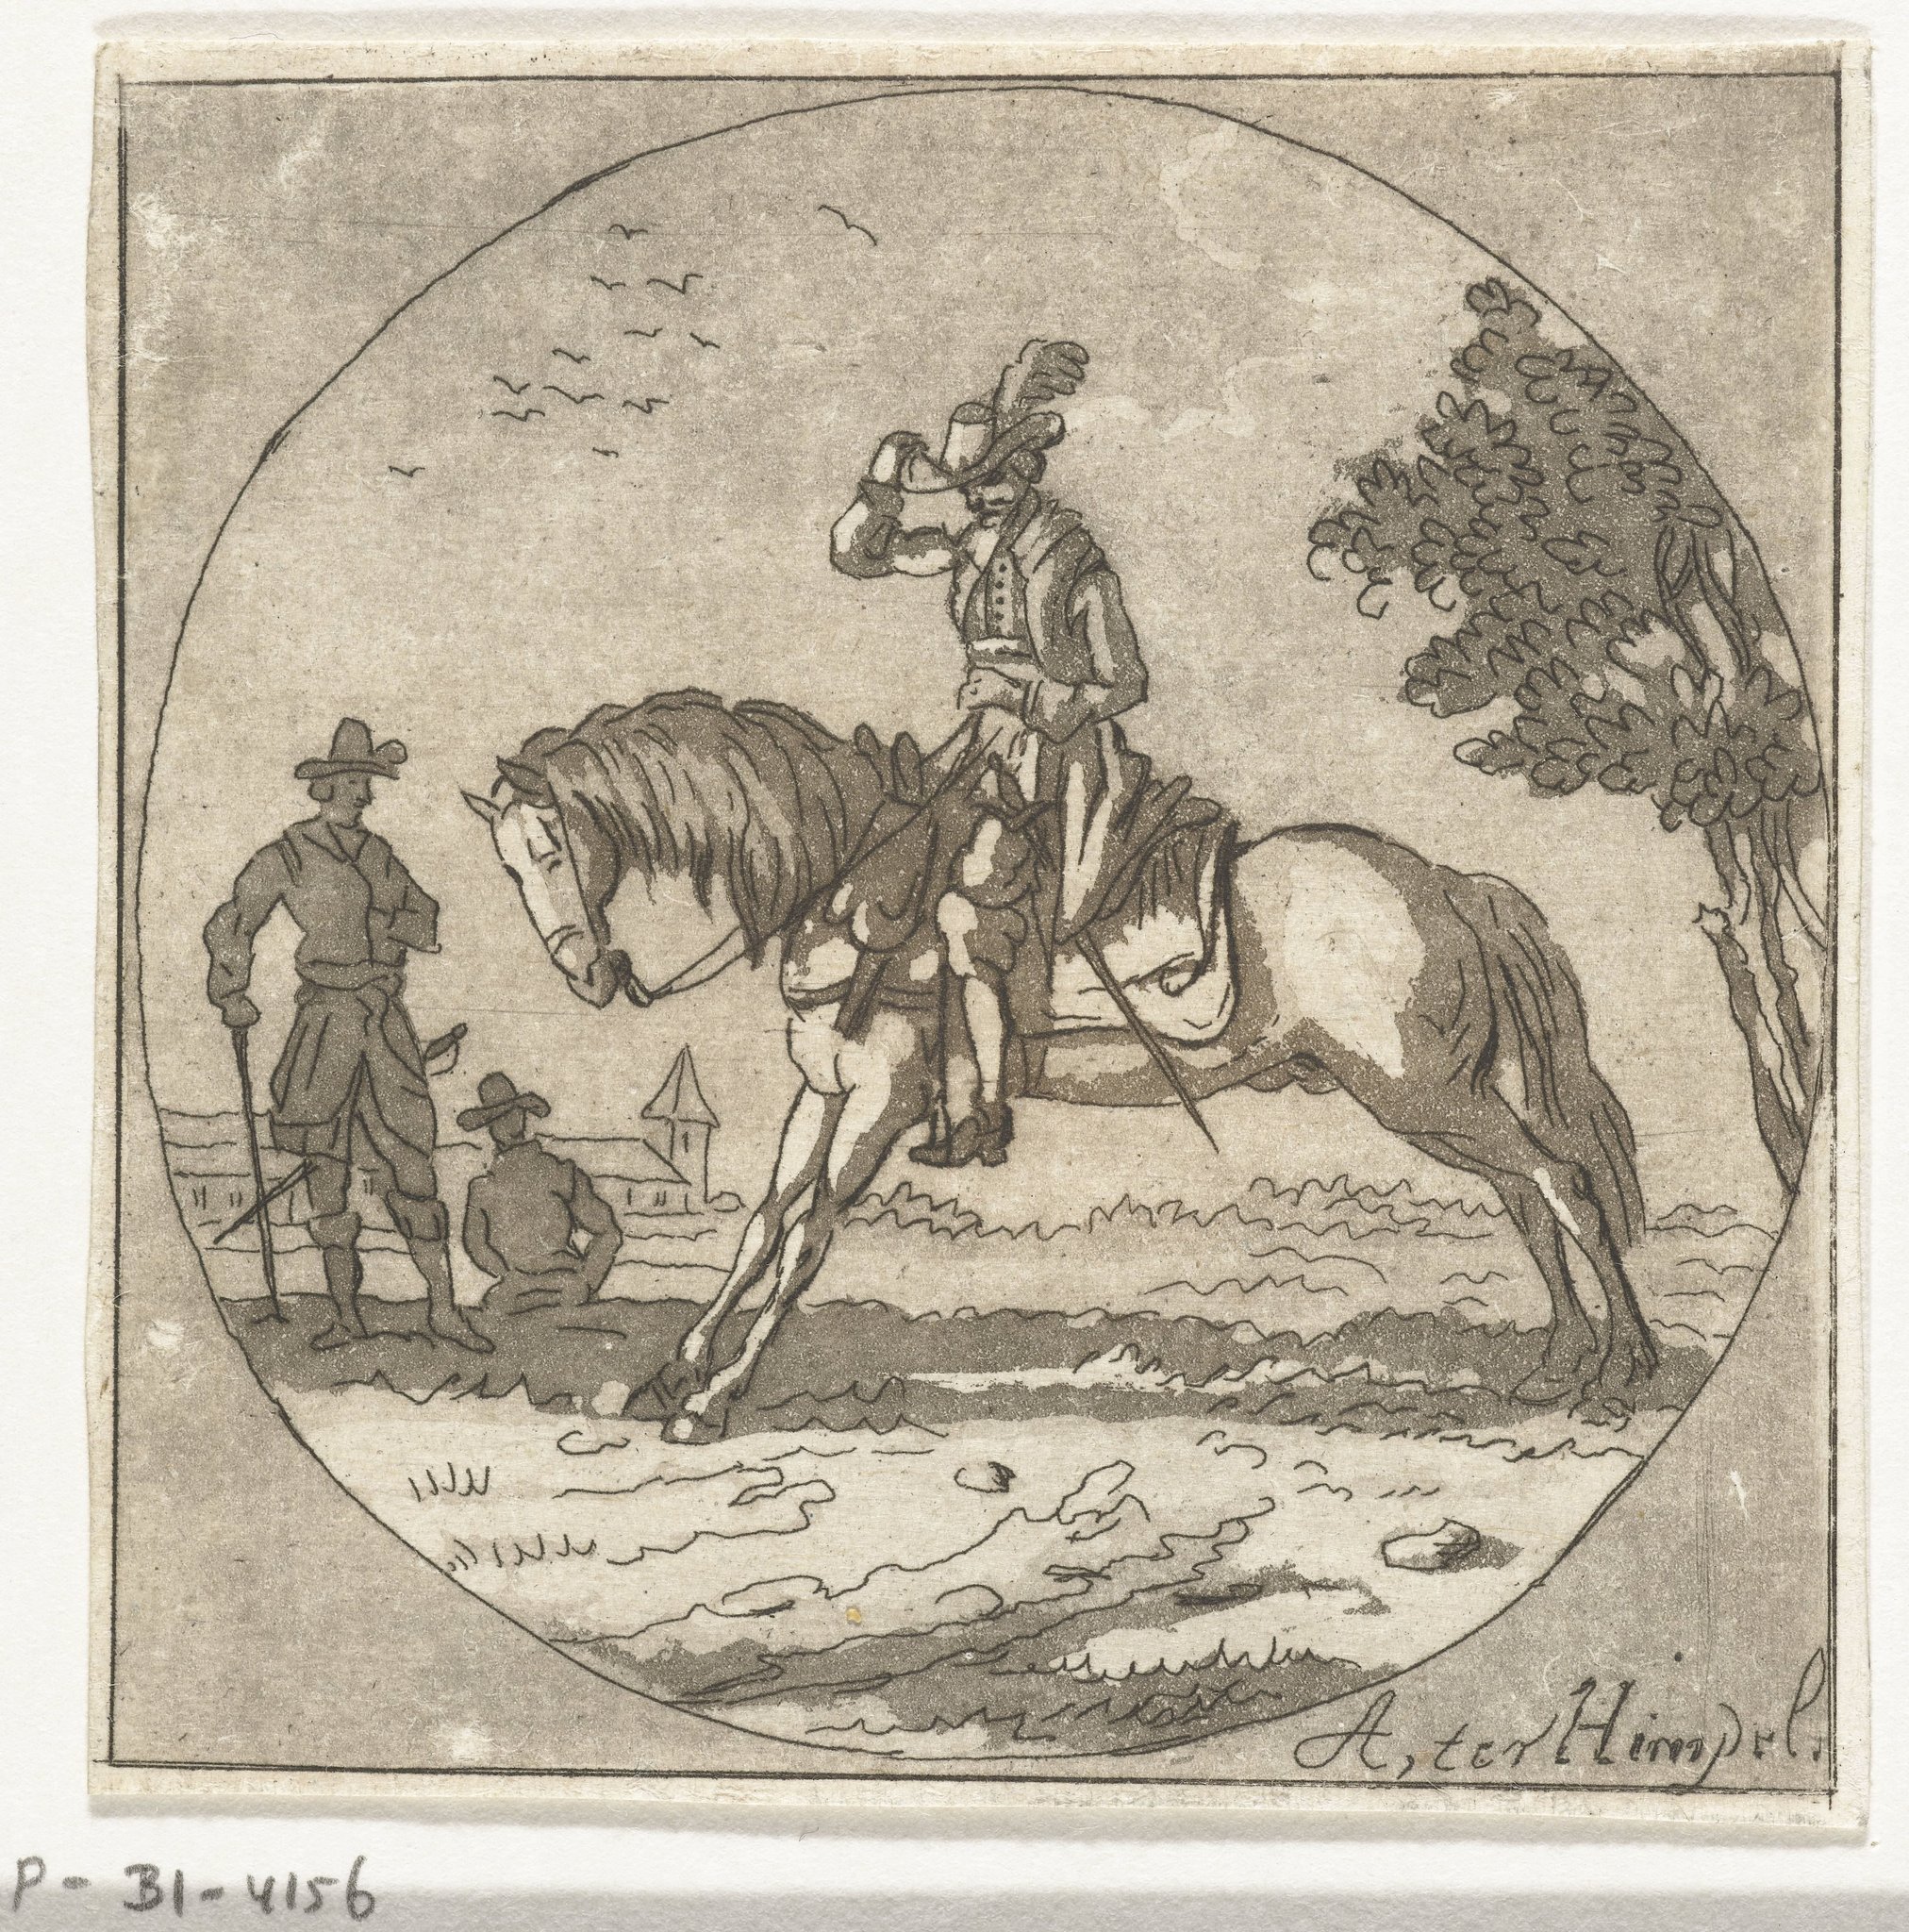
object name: print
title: Ruiter in medaillon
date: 1778-1838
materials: paper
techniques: aquatint, etching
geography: netherlands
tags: riding a horse, ass, or mule; rider, horseman, baring the head, lifting one's hat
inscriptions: collector's mark: Lugt 2228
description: Een ruiter te paard groet twee mannen die langs de weg staan.